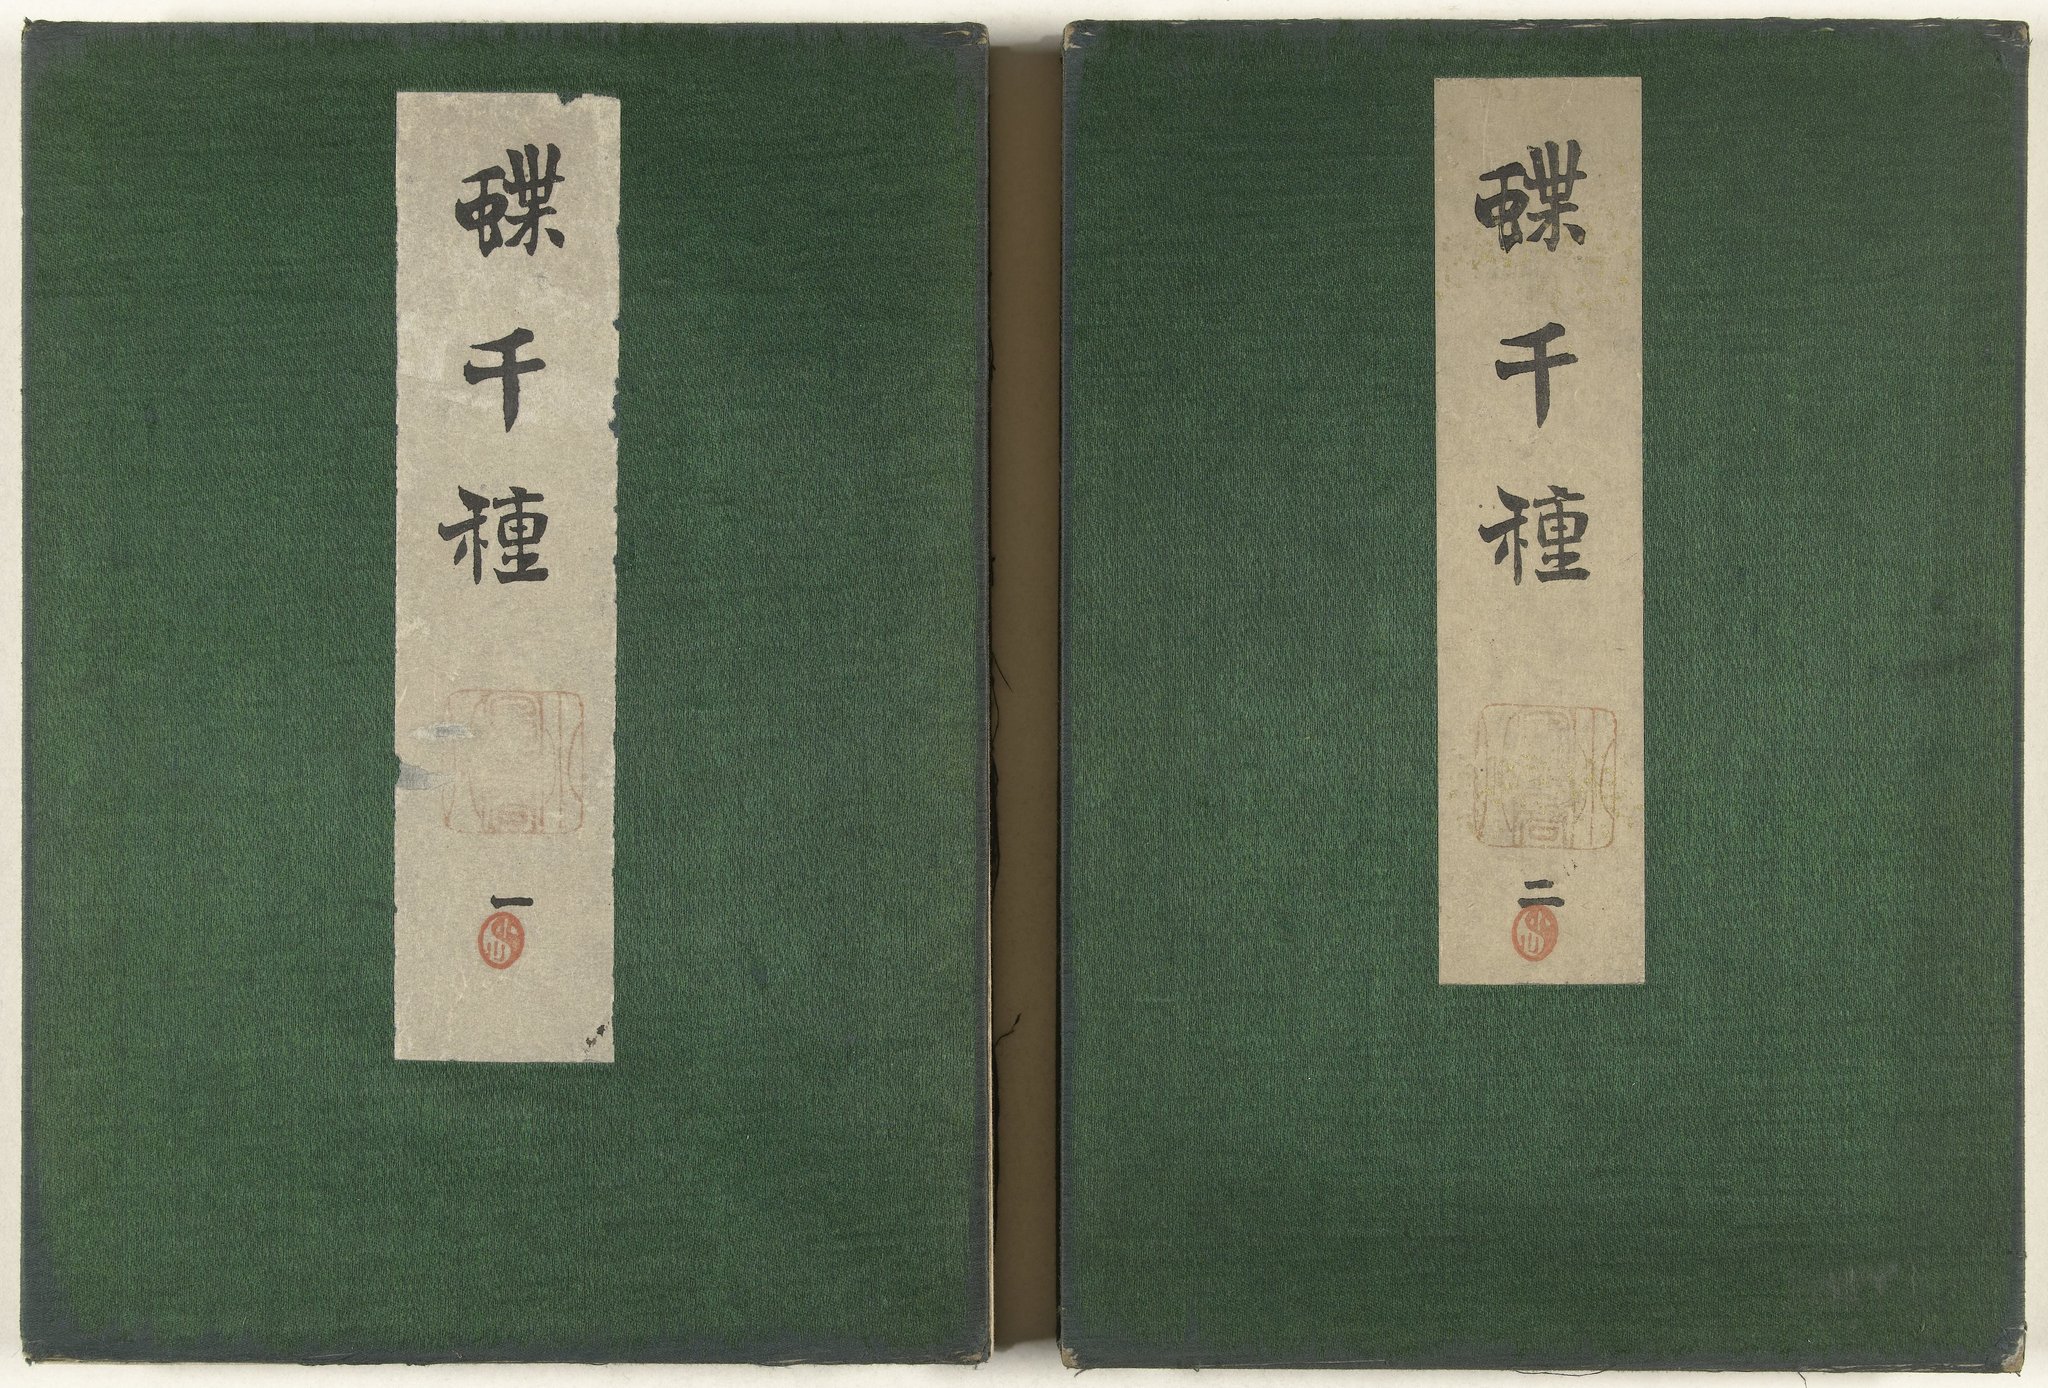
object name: book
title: Cho senshu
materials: paper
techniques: woodcut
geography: kyoto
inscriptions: date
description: Dit object is omwille van een betere presentatie virtueel samengevoegd, maar bestaat fysiek uit losse onderdelen.